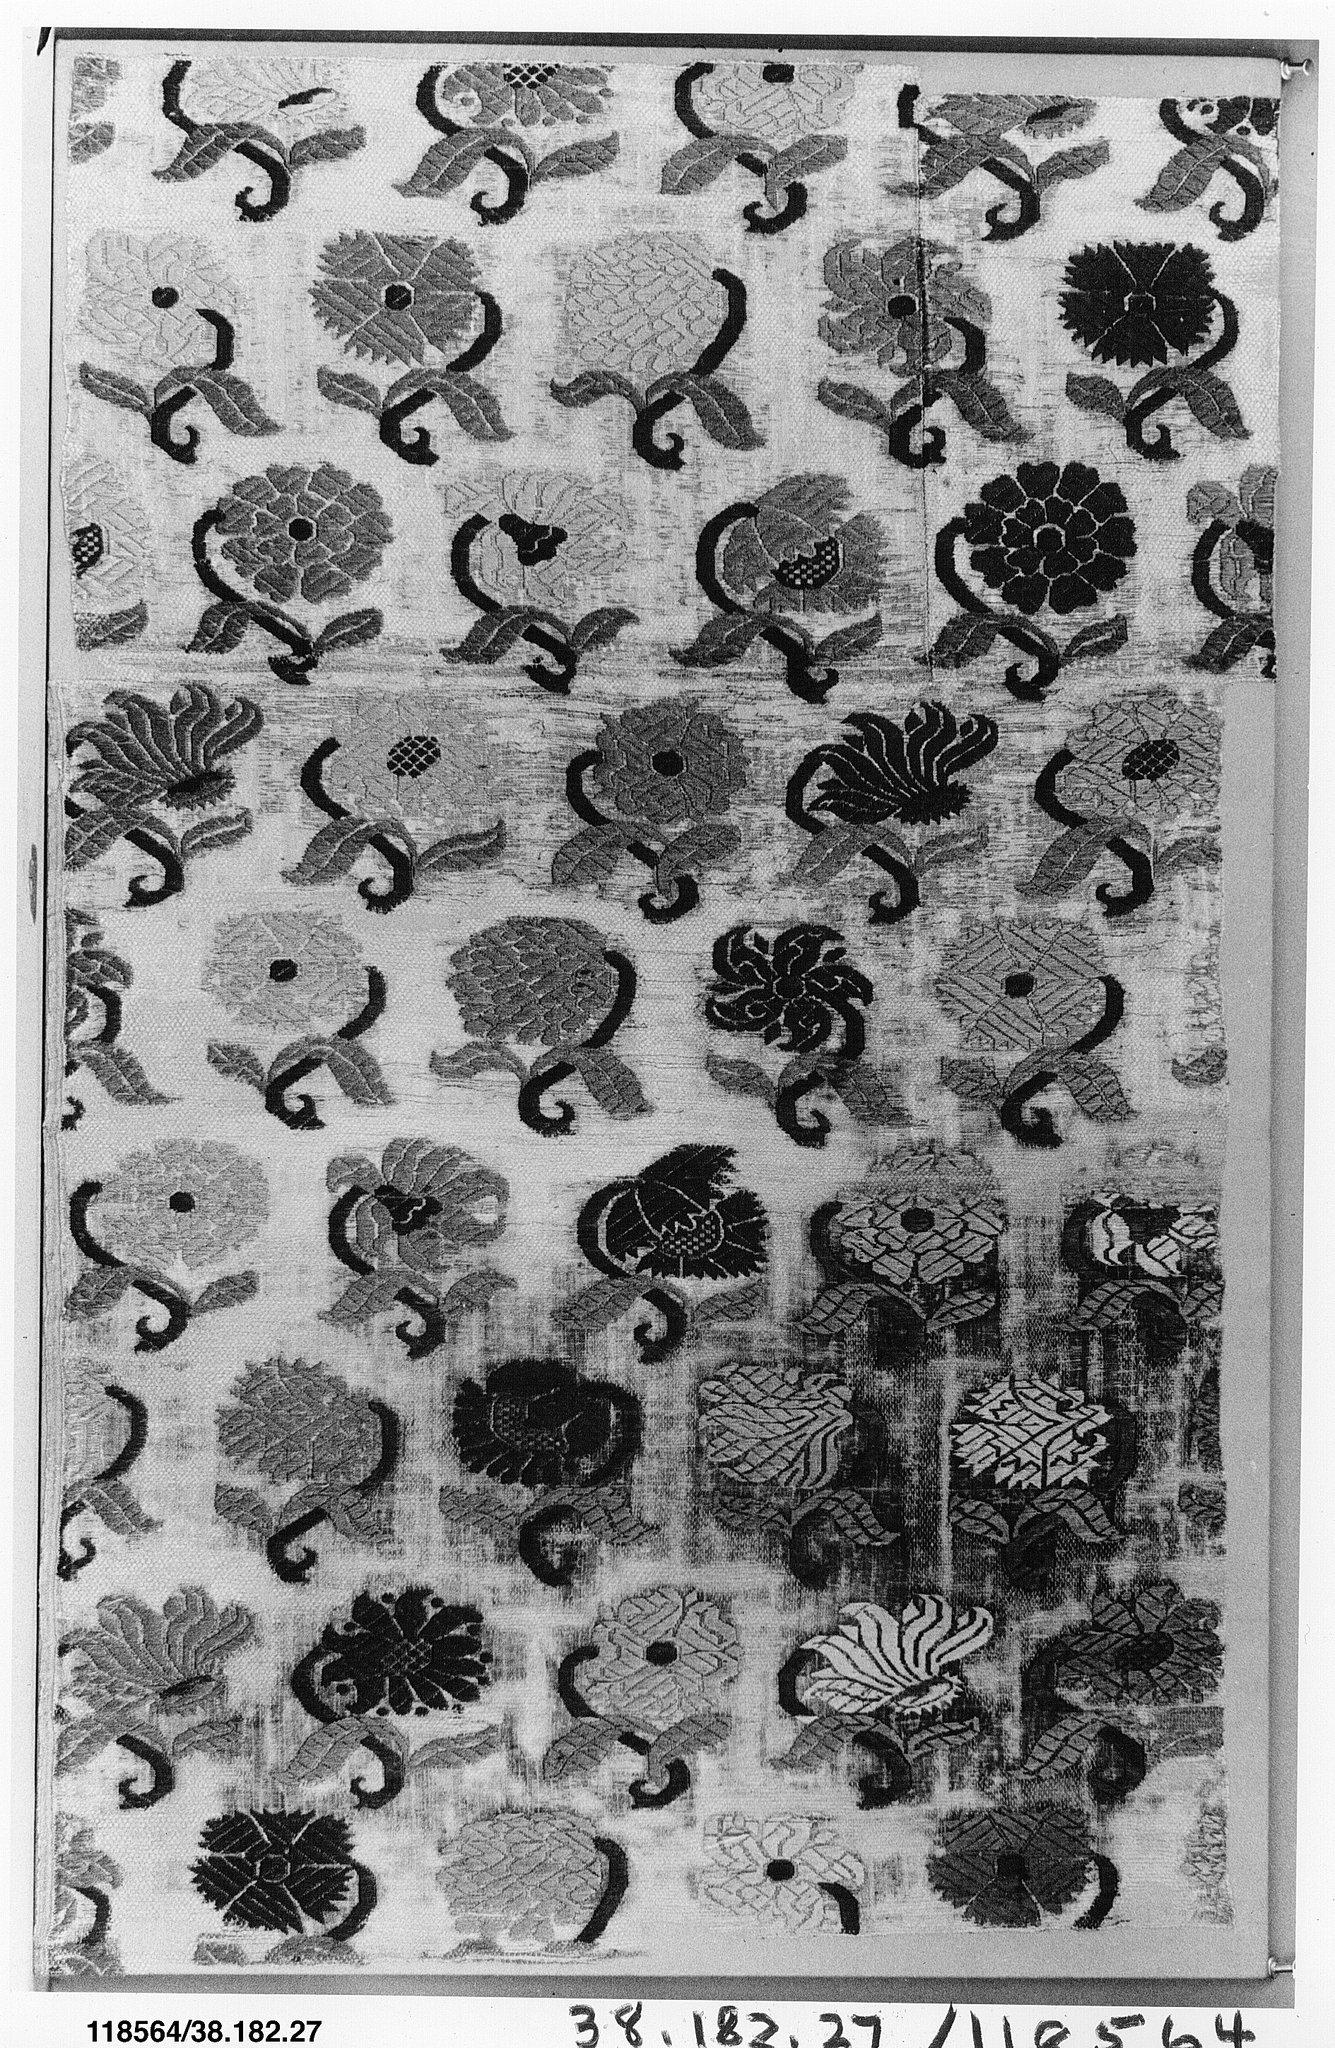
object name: piece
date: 1600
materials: metal thread, silk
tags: flowers,leaves